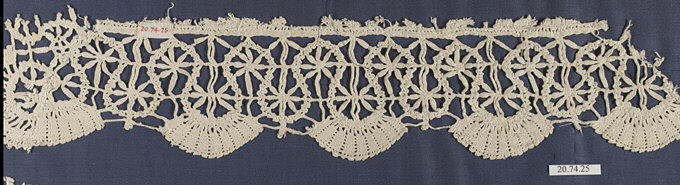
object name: fragment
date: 1601-1700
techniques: lace